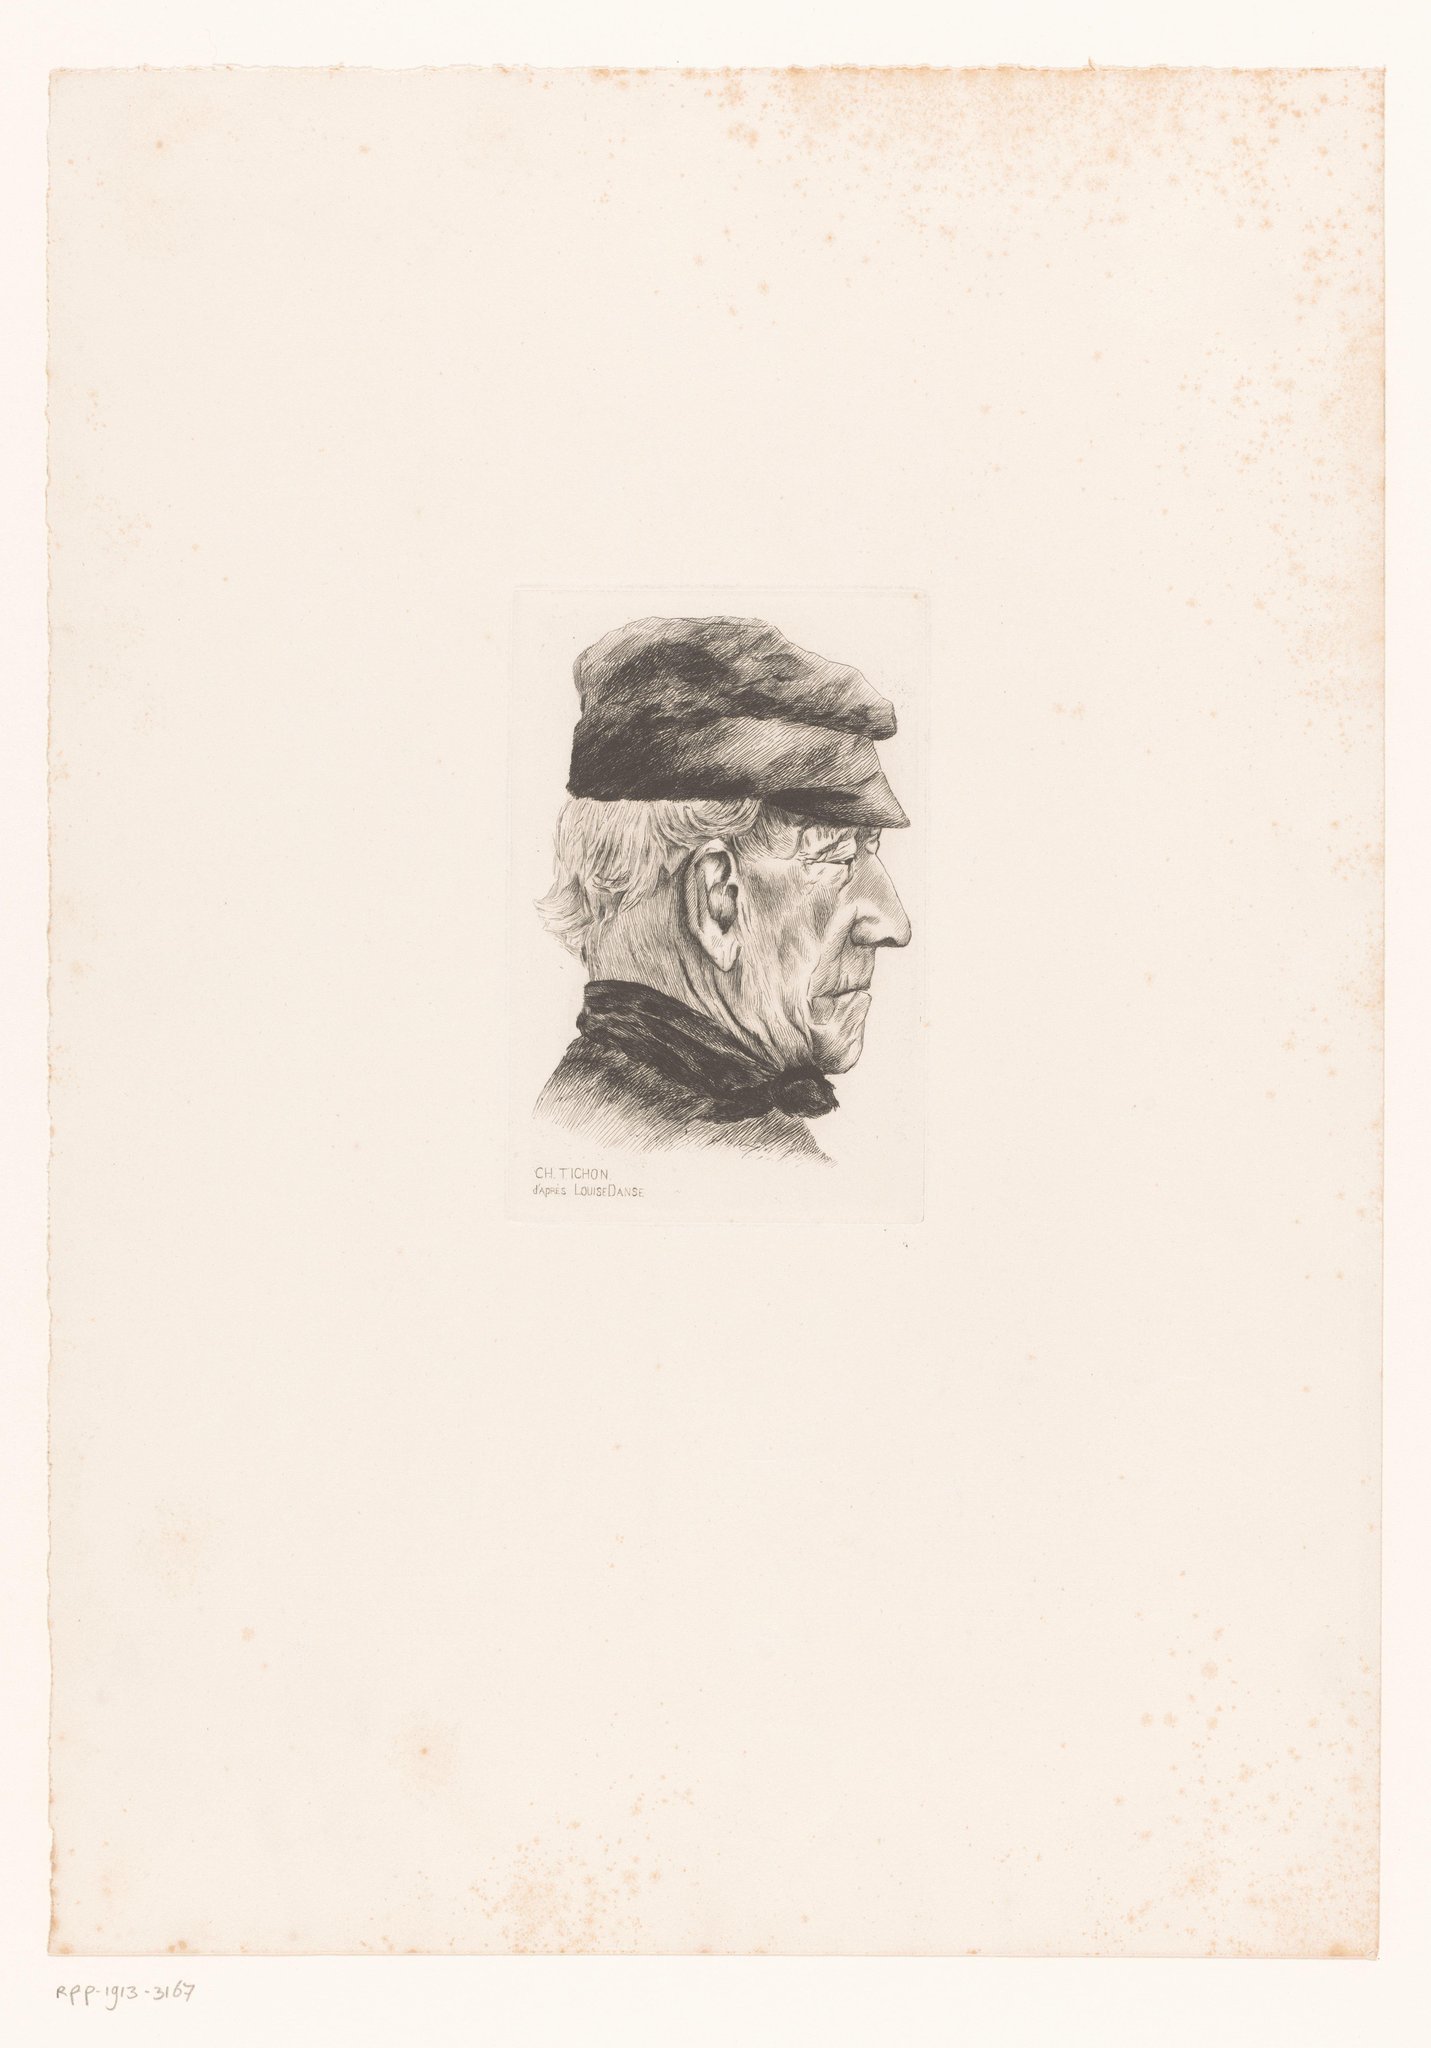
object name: print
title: Hoofd van een onbekende man met pet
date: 1883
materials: paper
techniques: etching, retroussage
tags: head-gear, adult man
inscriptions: collector's mark: Lugt 2228